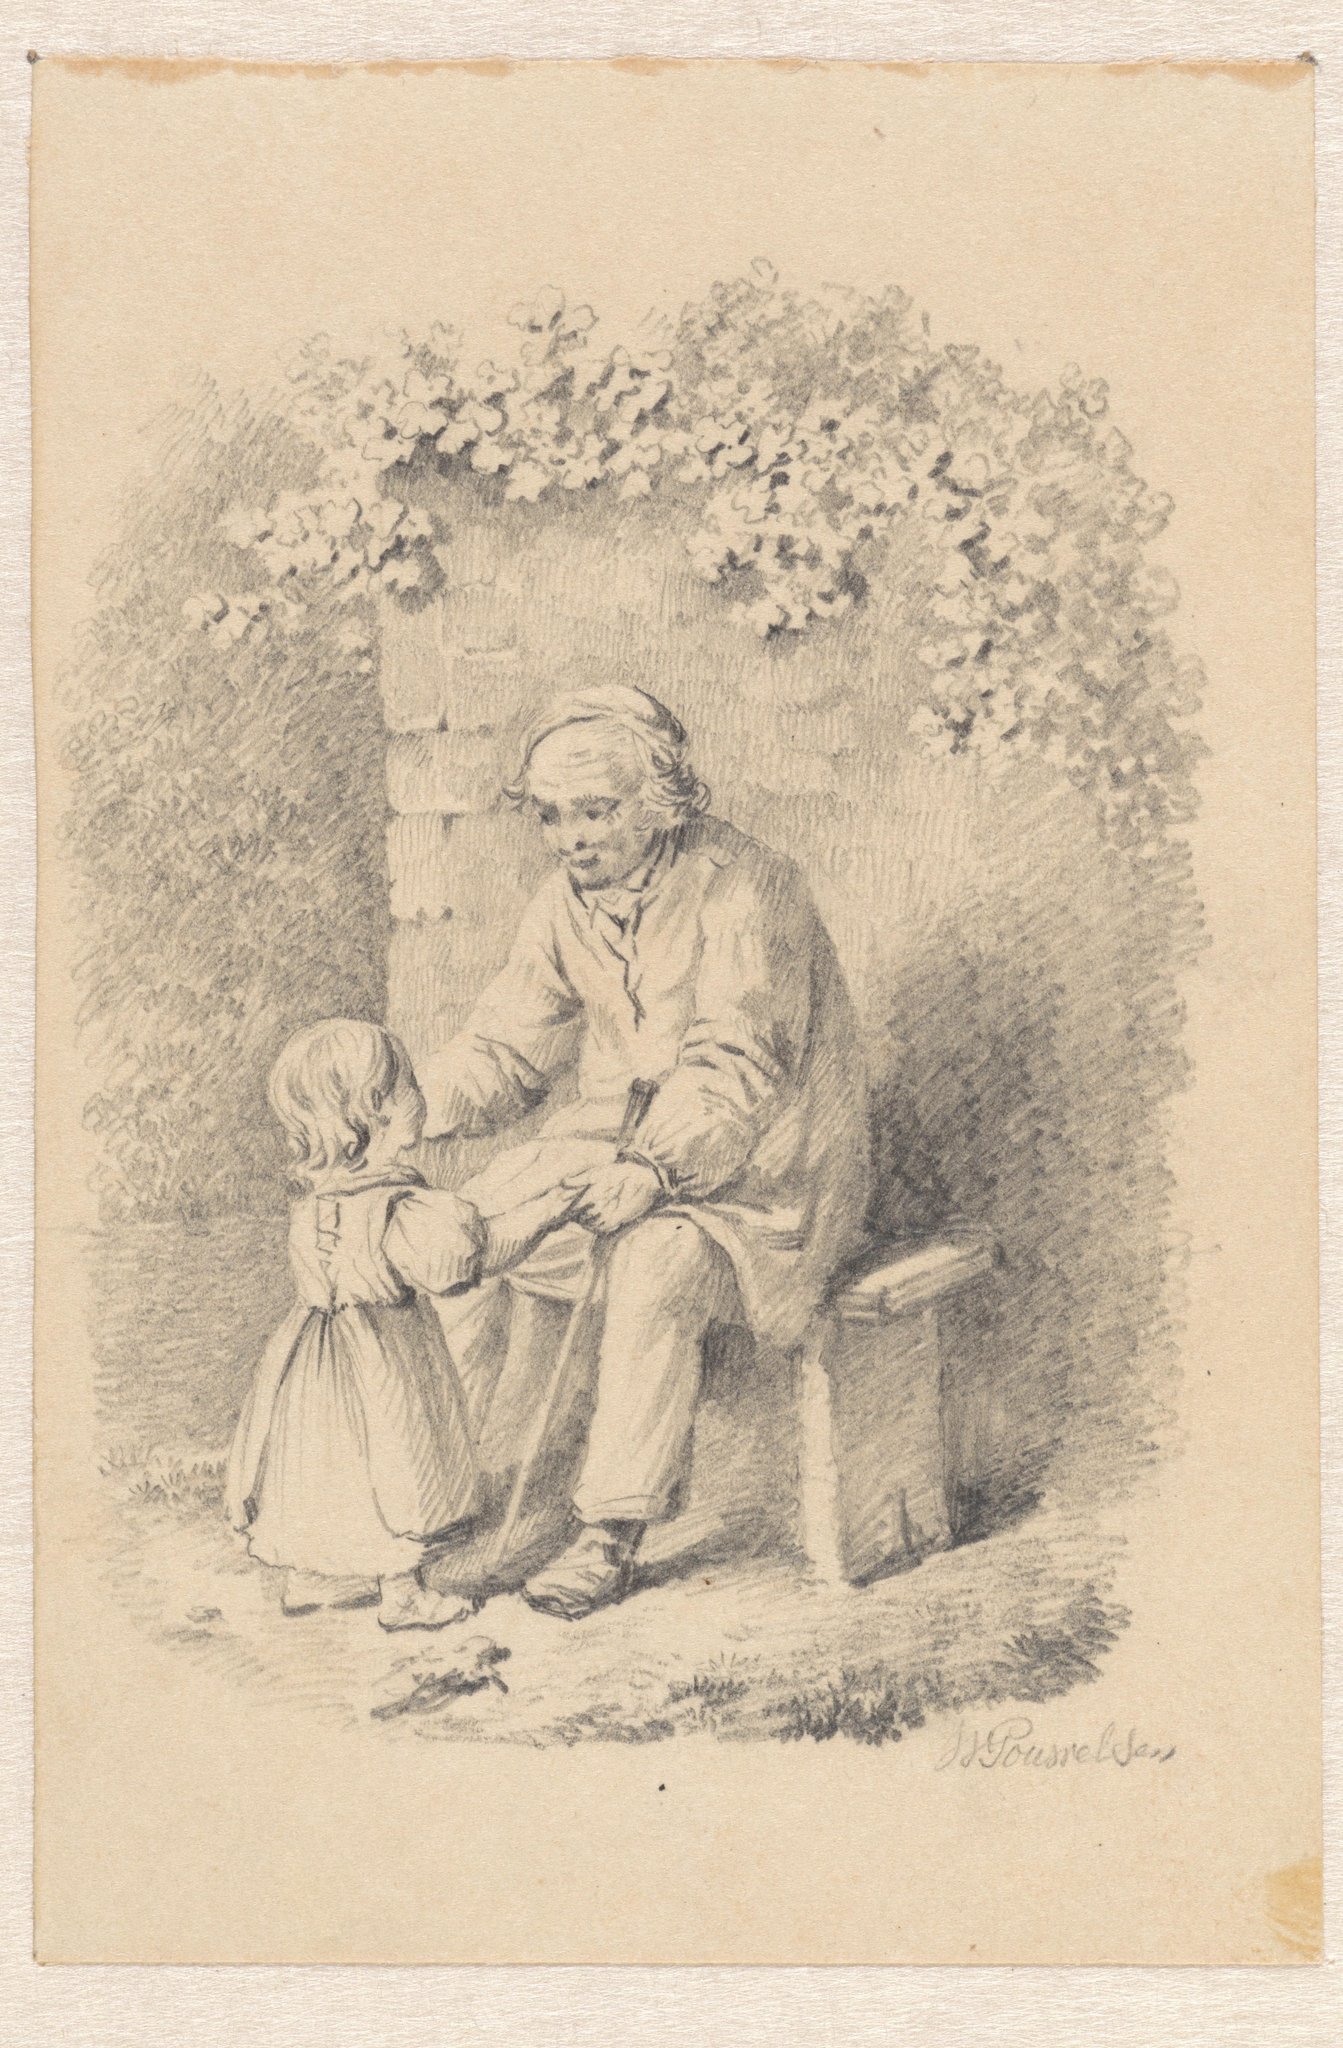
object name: drawing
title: Man houdt een kindje bij de handen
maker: willem pouwelsen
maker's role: draughtsman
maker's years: 1801-1873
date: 1811-1873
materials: paper, pencil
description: Oude man op een bankje gezeten, houdt een kindje bij de handen.